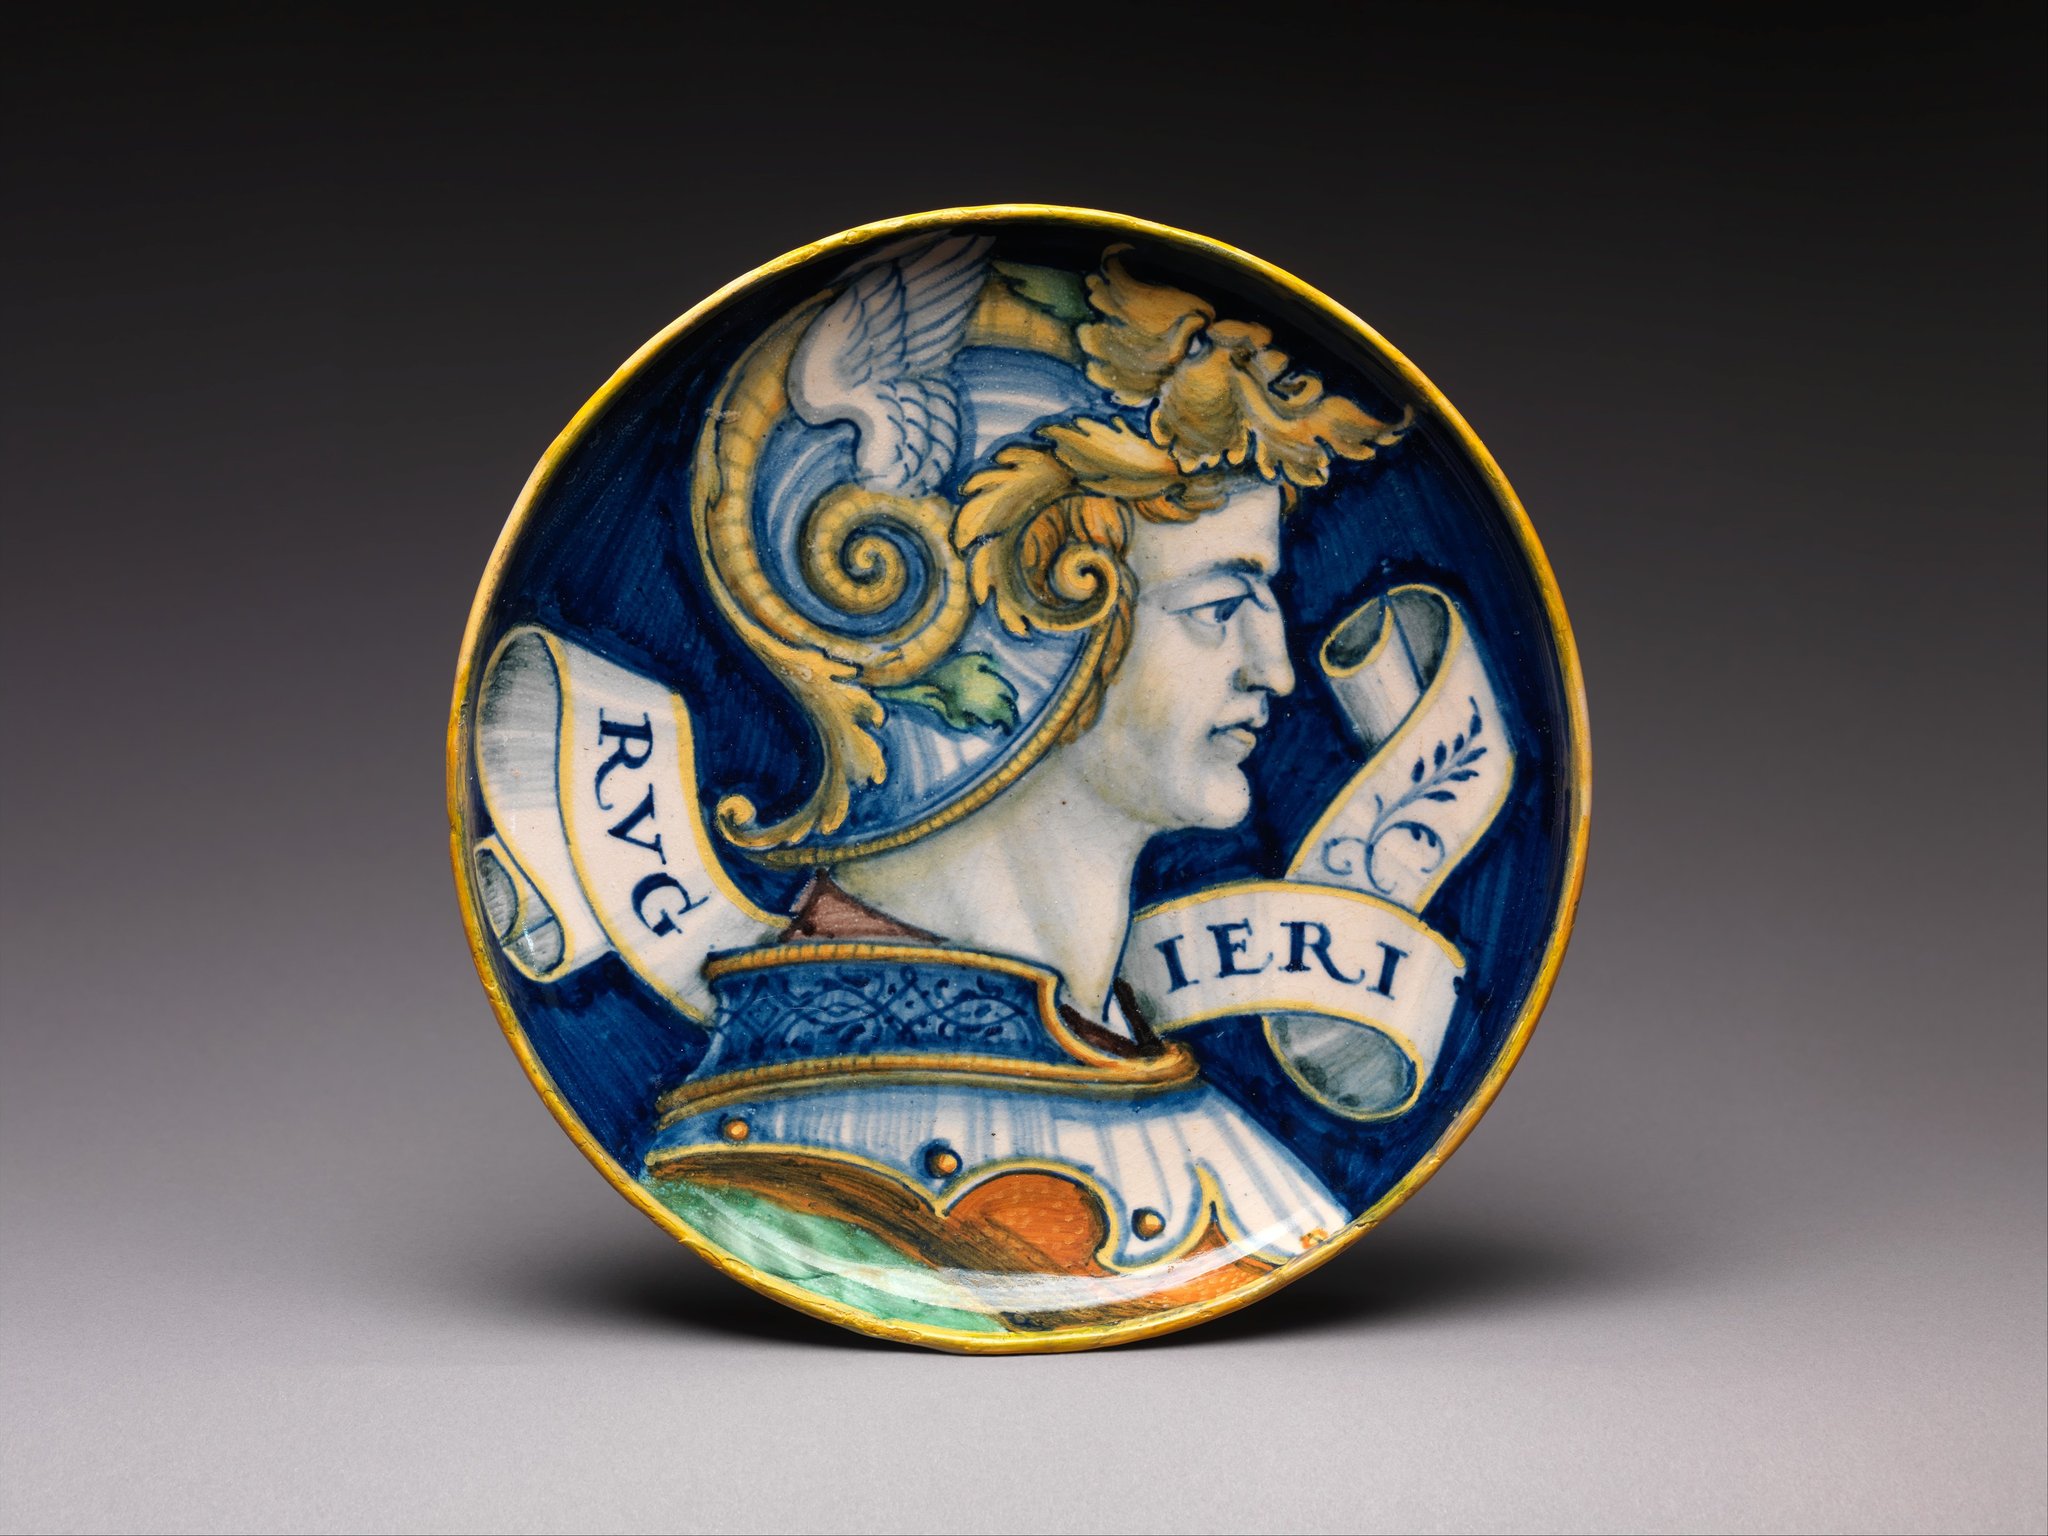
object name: bowl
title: Shallow bowl with Ruggiero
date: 1525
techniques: maiolica, glazing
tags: helmets,men,profiles